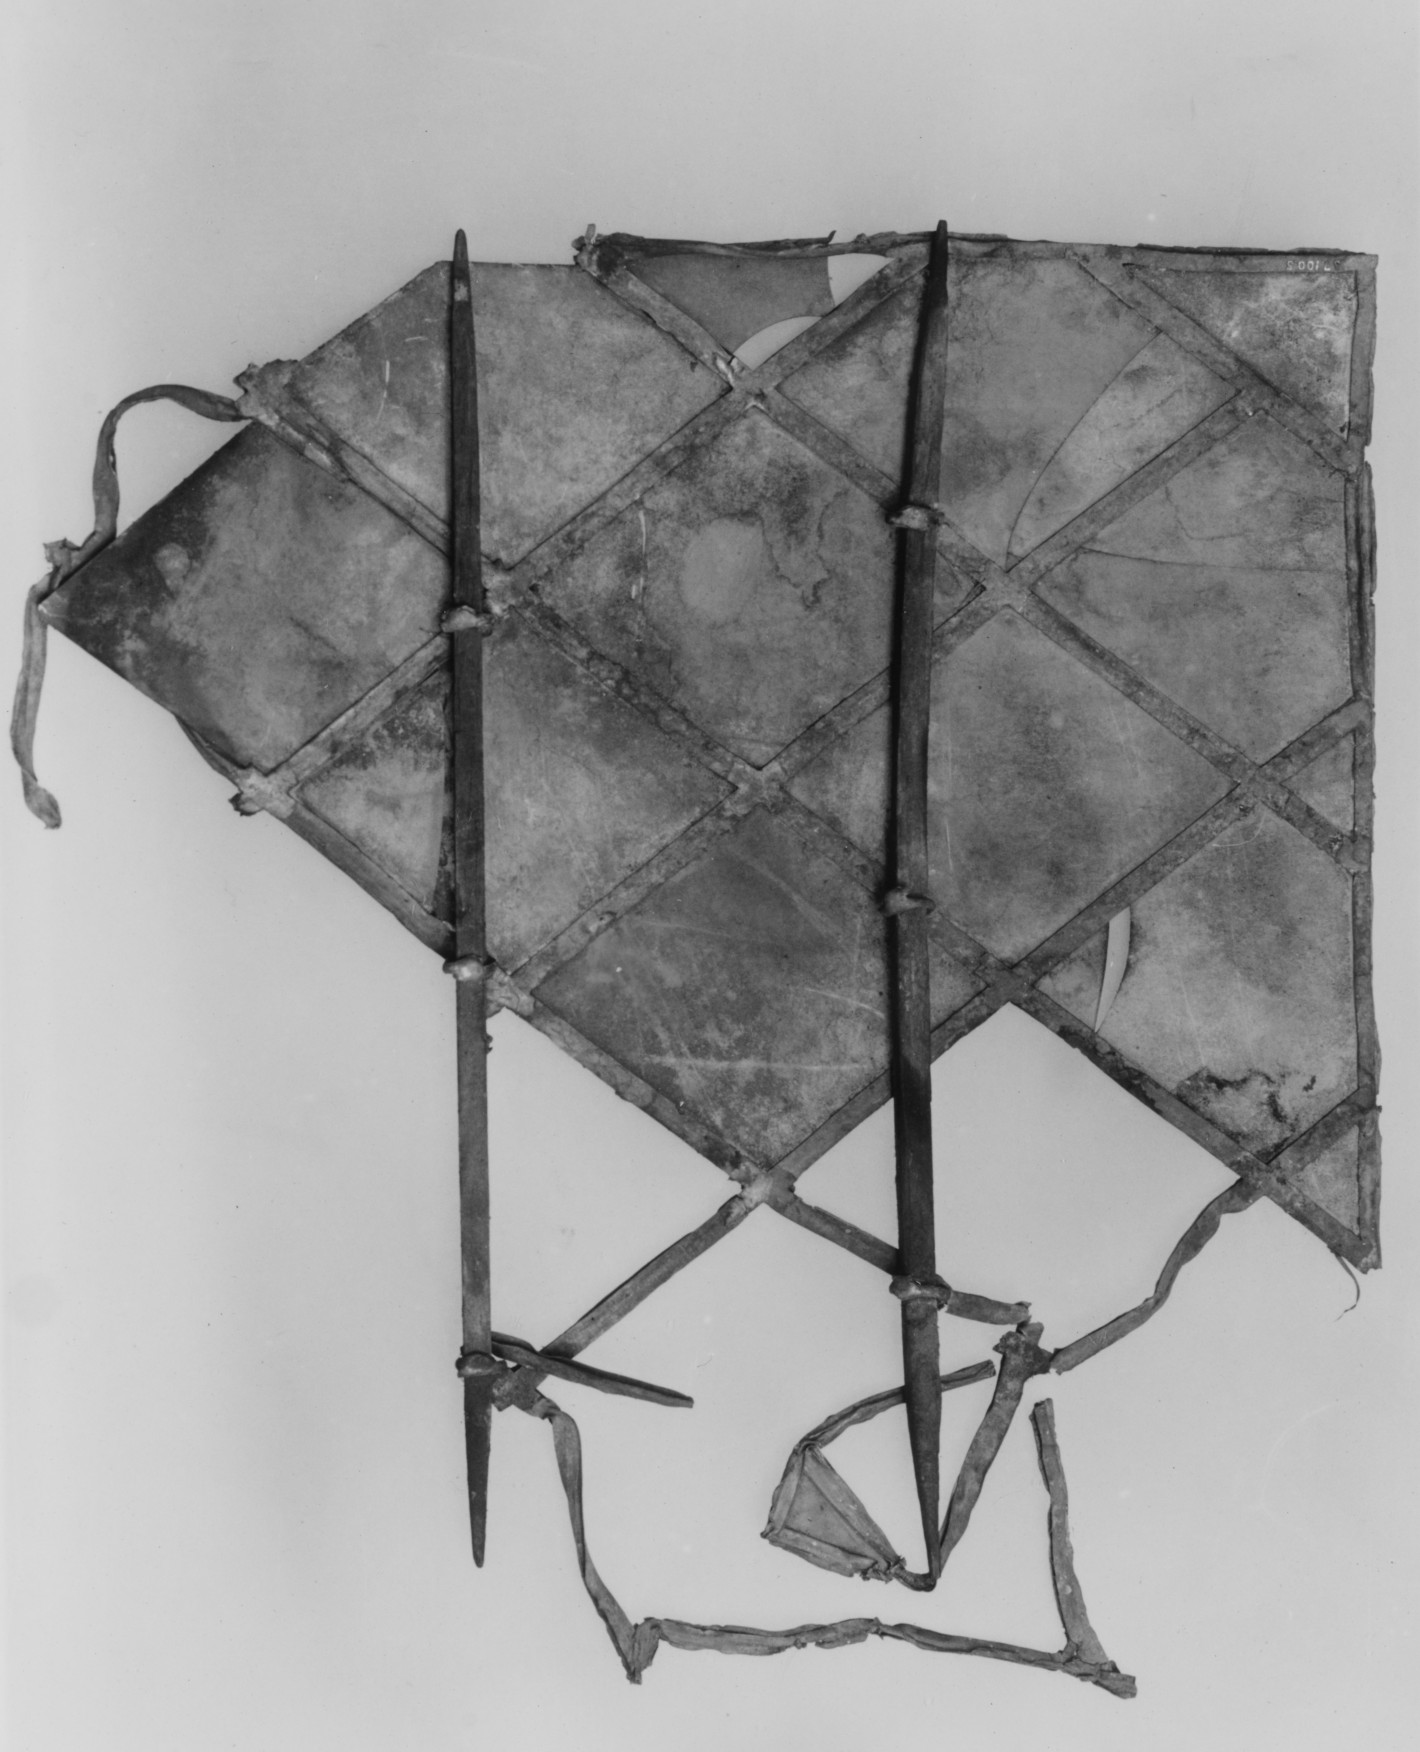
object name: casement window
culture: american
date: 1600-1700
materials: glass, lead, wood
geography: united states